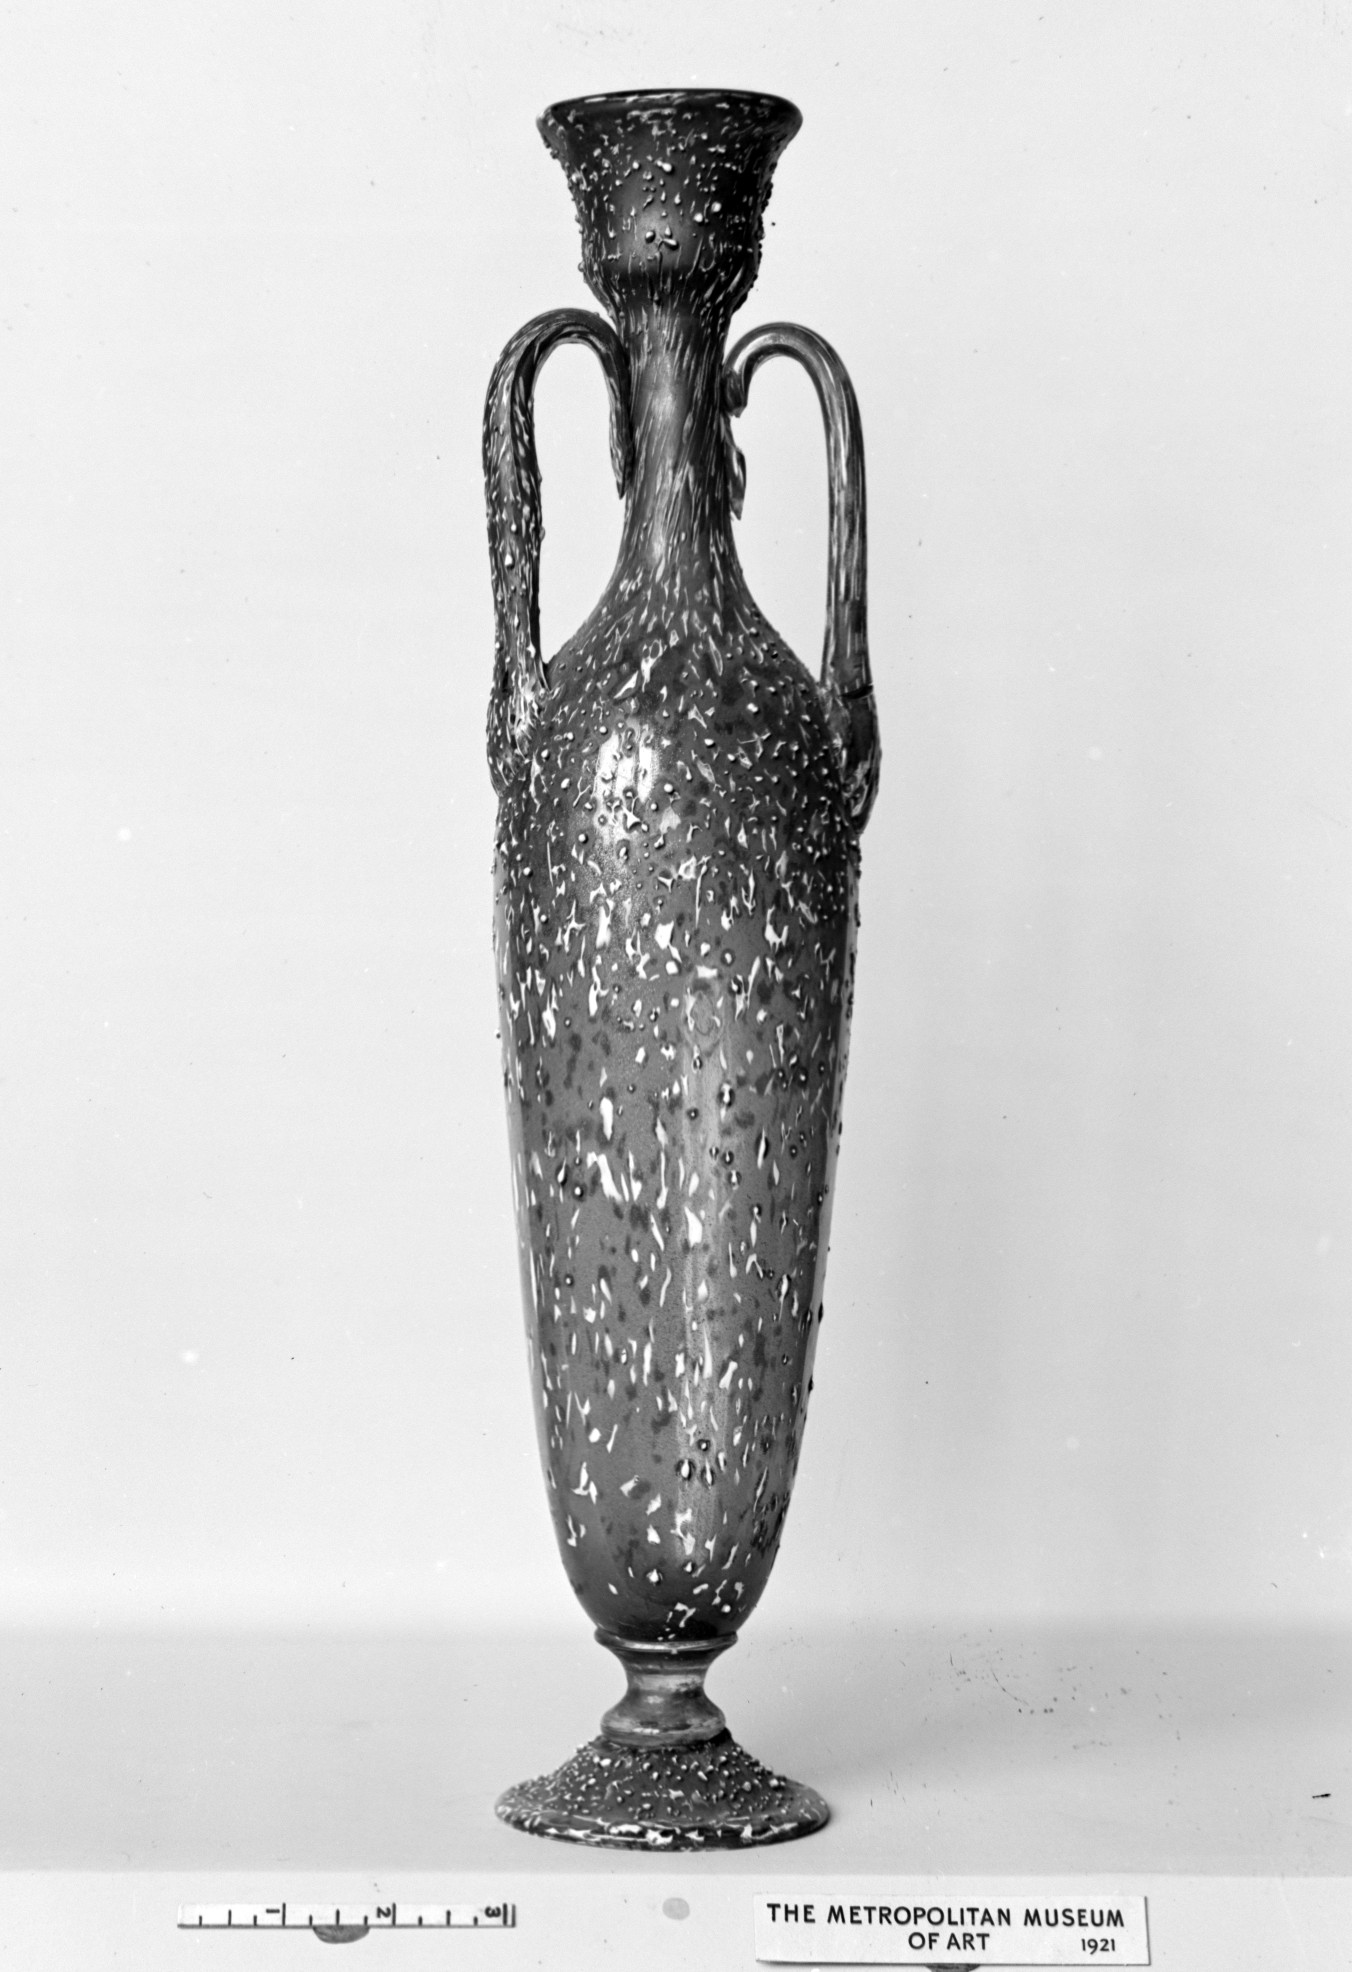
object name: vase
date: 1801-1900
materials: glass